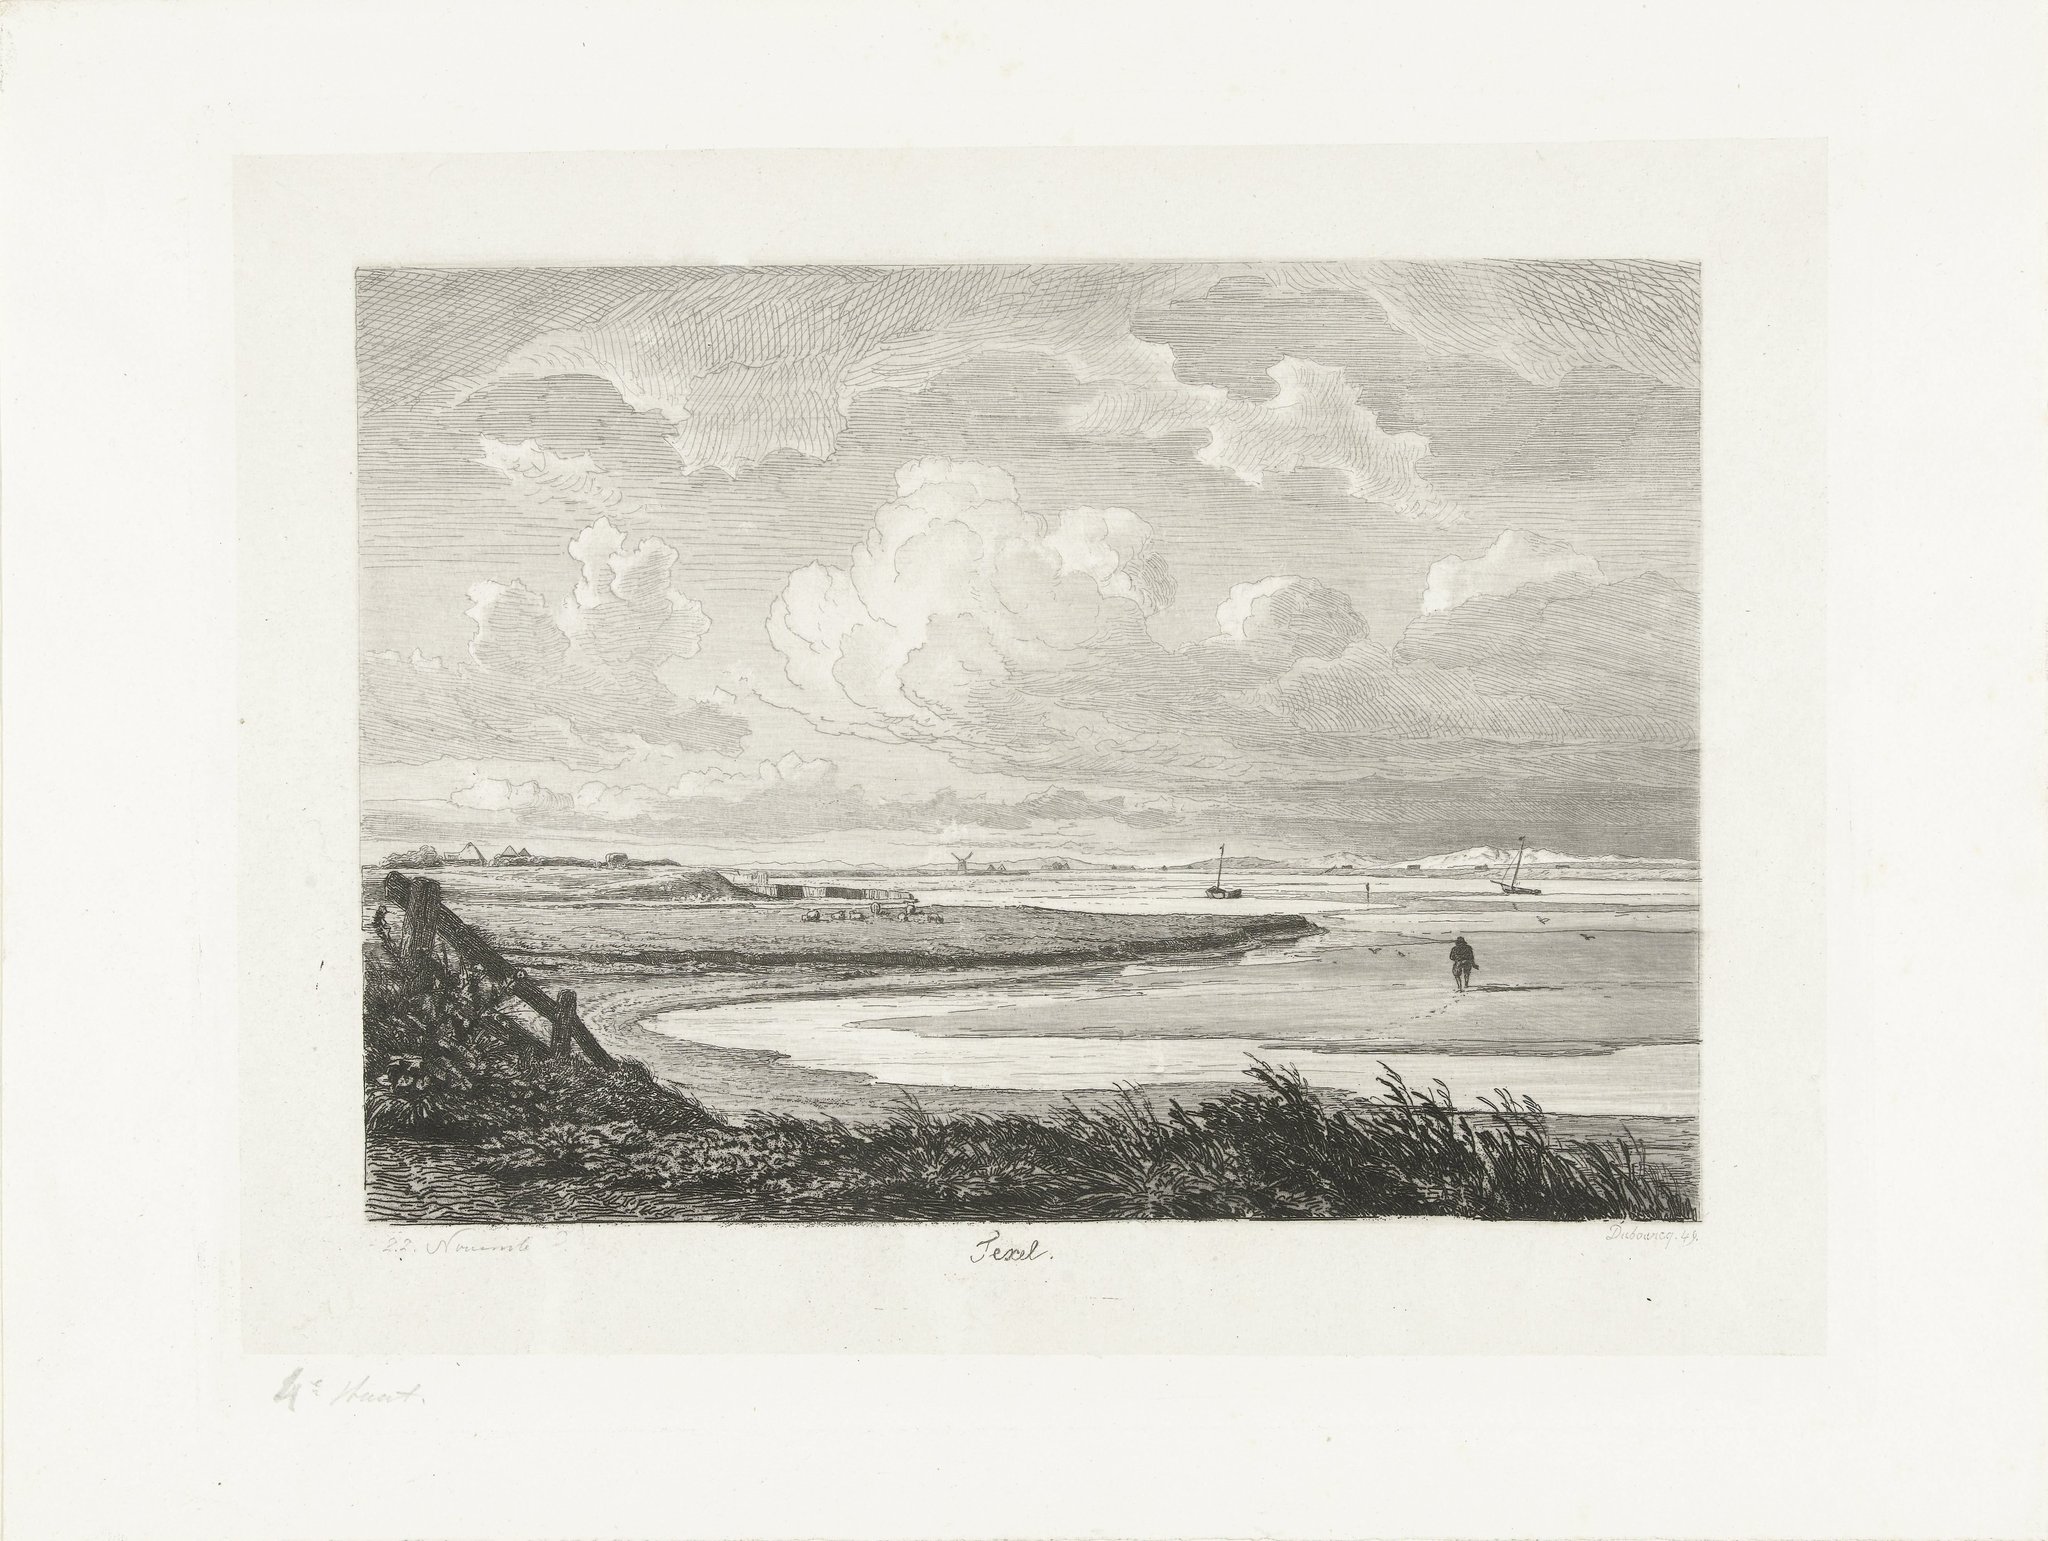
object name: print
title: Zes etsproeven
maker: pierre louis dubourcq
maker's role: draughtsman, painter, print maker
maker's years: 1815-1873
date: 1849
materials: paper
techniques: drypoint, etching, intaglio, roulette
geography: netherlands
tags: gulf, bay, mud flat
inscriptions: collector's mark: Lugt 2228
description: Gezicht op een baai aan de kust van Texel met een wadloper. Aan de overkant van de baai een kudde schapen. Twee boten zijn gedurende de eb droog gevallen.